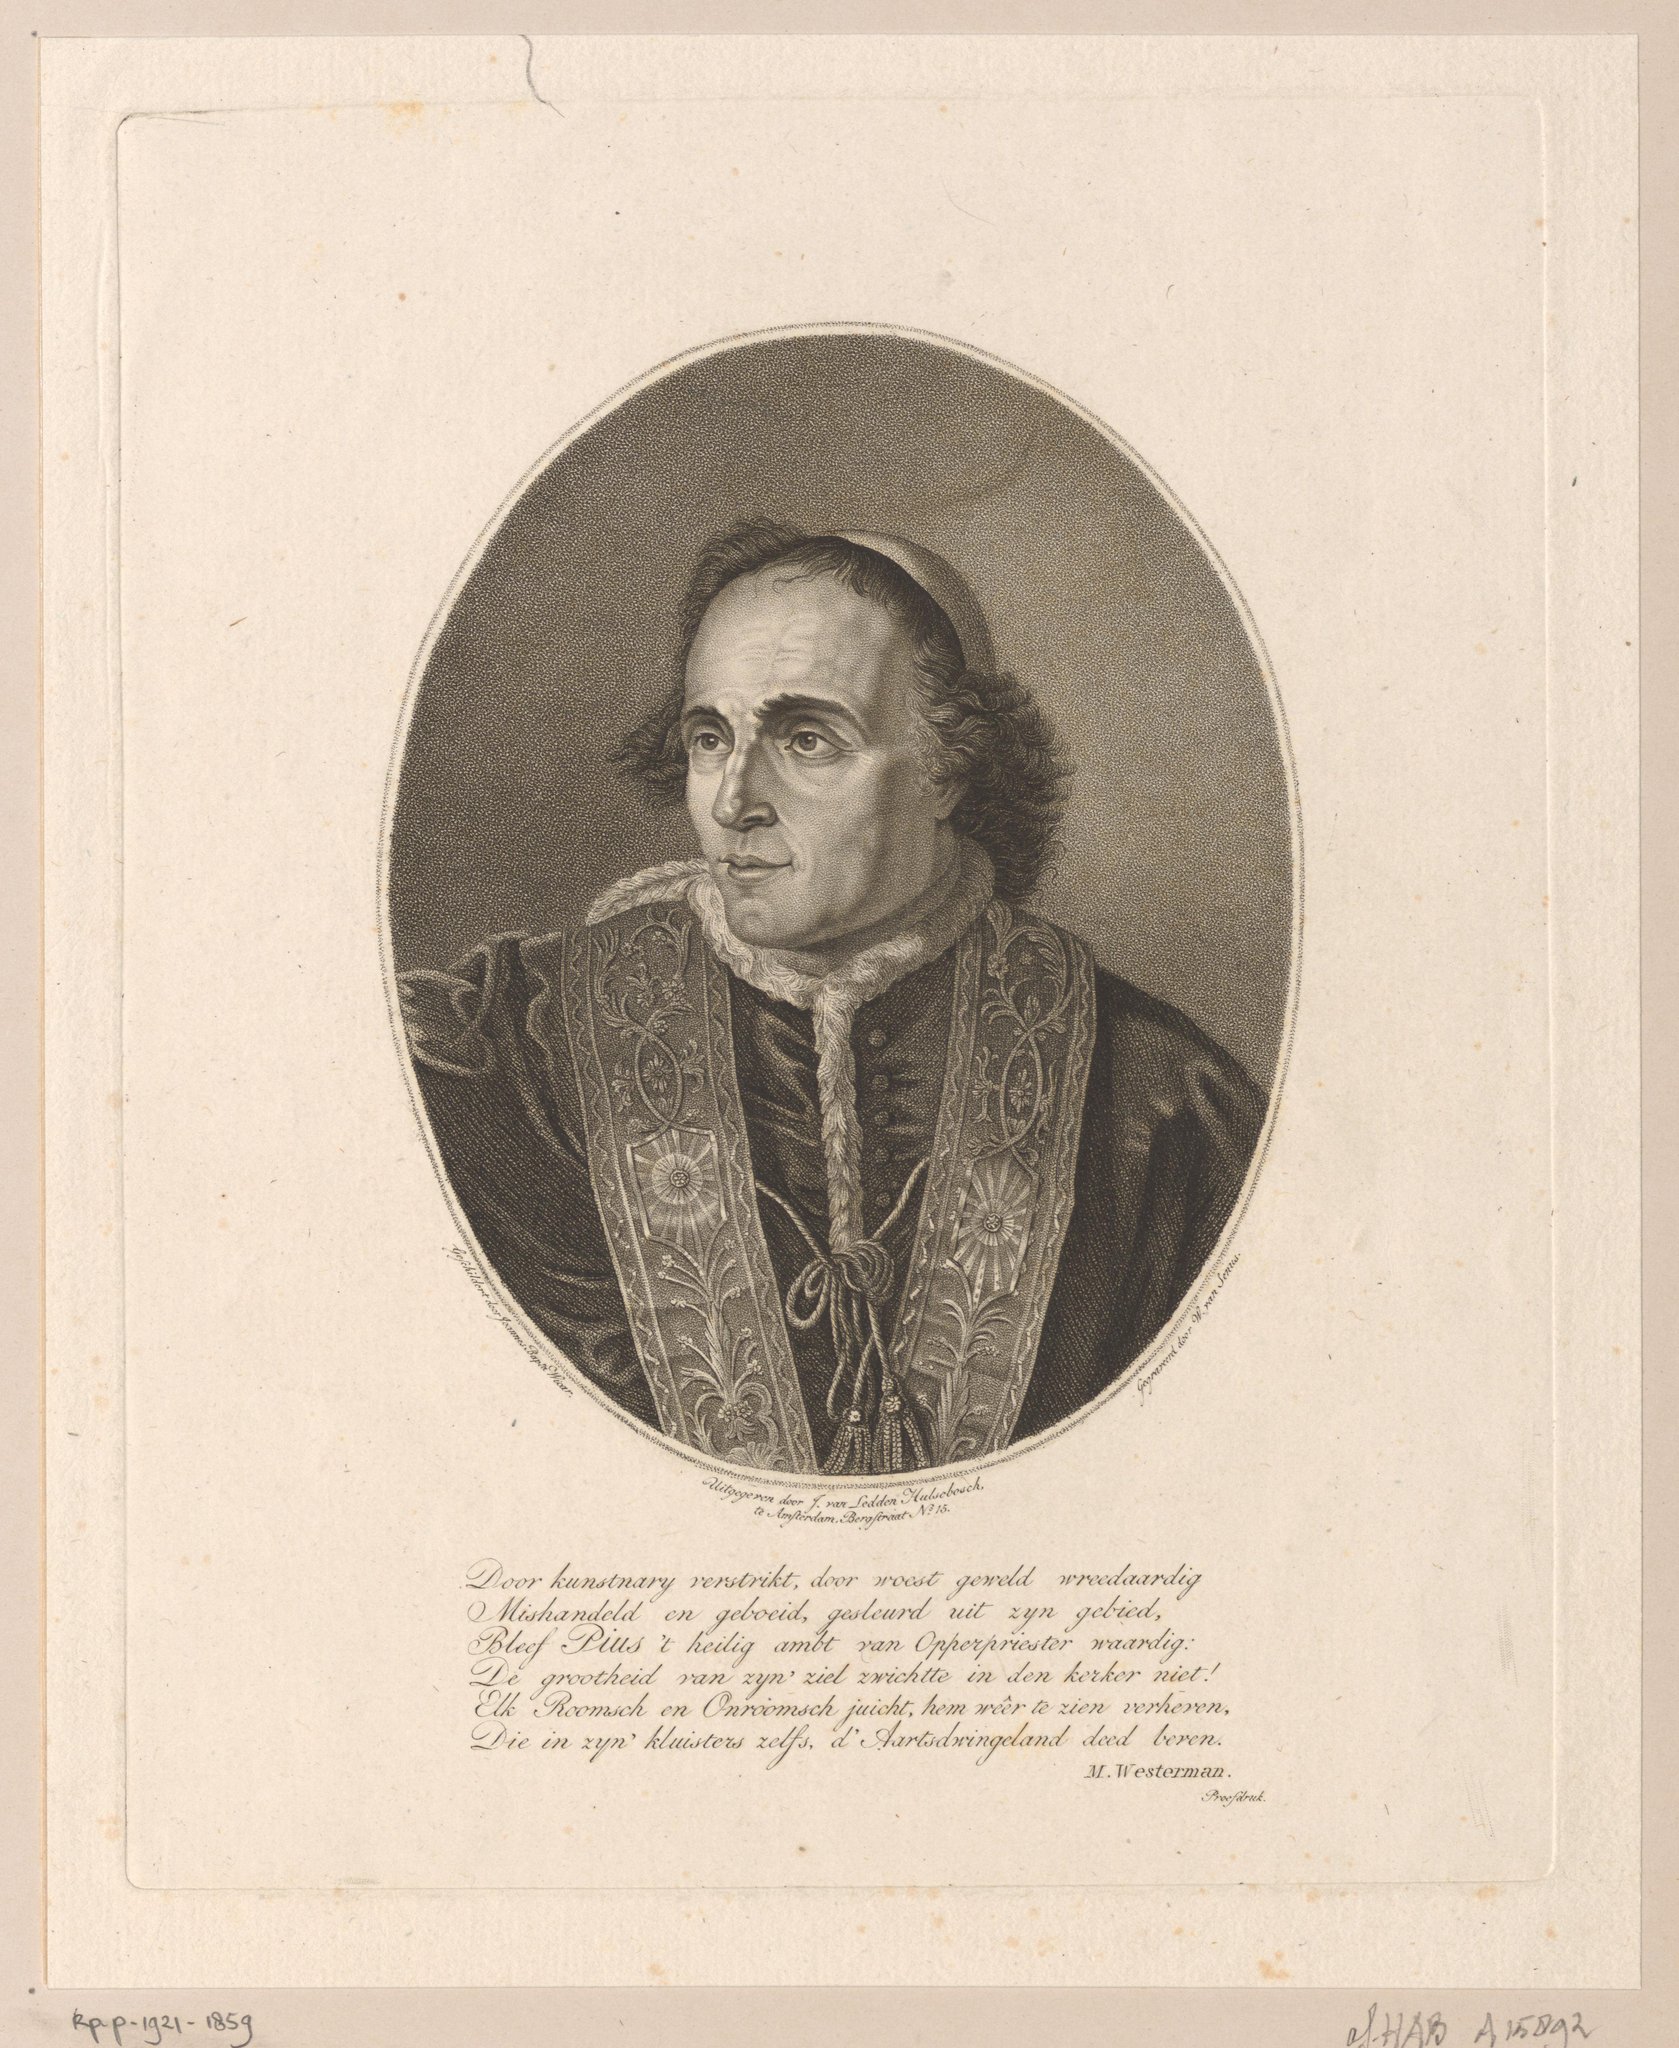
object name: print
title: Portret van paus Pius VII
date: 1808-1819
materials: paper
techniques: engraving, etching, roulette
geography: amsterdam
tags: clergyman, pius vii, historical persons, pope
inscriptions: collector's mark: Lugt 2233, inscription: ‘Pius VII Door Napoleon gevangen (...) terug 1814.’